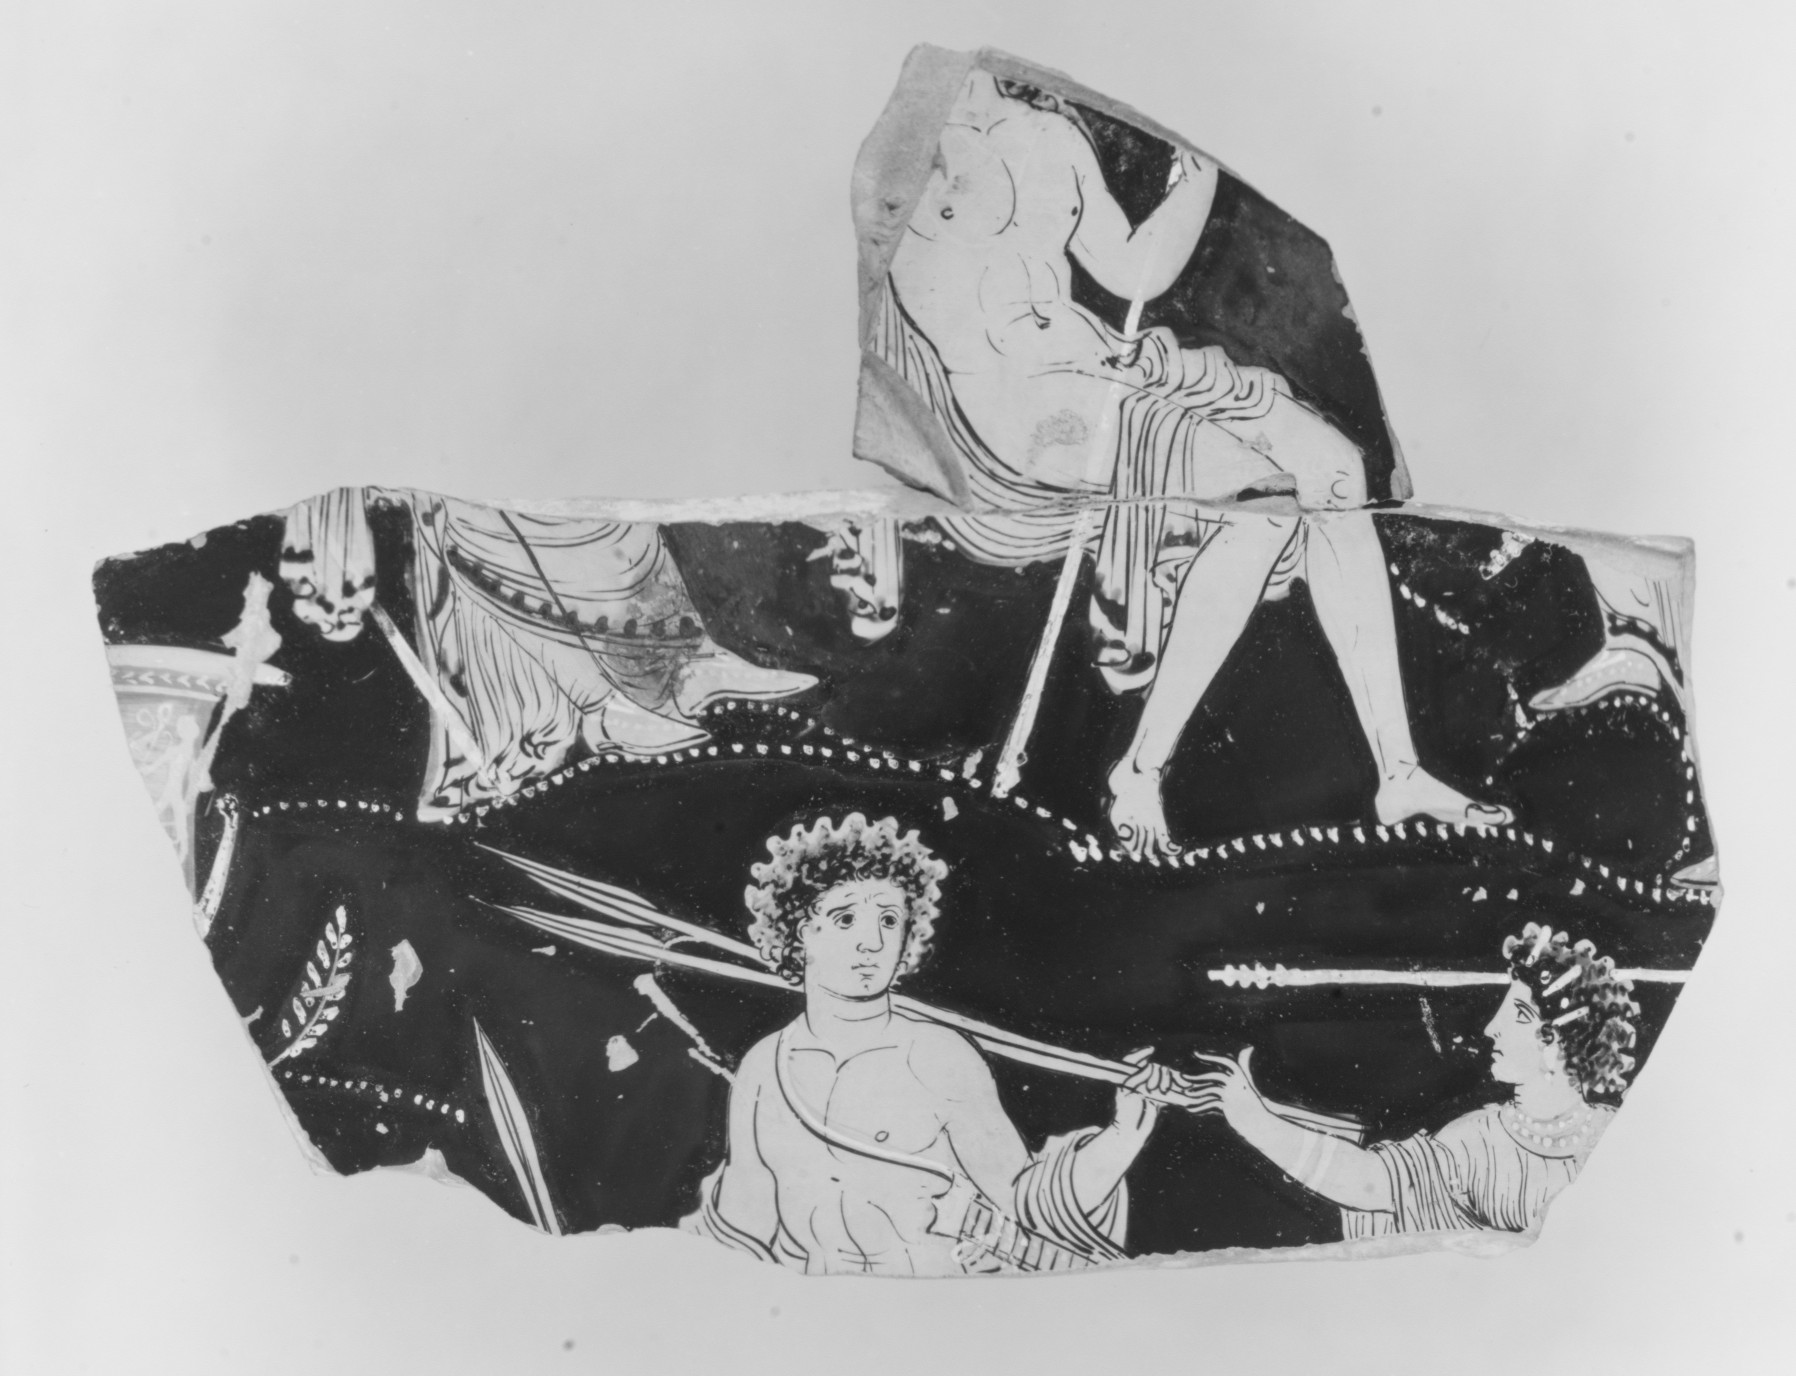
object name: volute krater fragment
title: Fragment of a terracotta volute-krater (bowl for mixing wine and water)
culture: greek, south italian, apulian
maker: painter of the dublin situlae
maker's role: artist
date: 367-335 BCE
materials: terracotta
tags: spears,swords,men